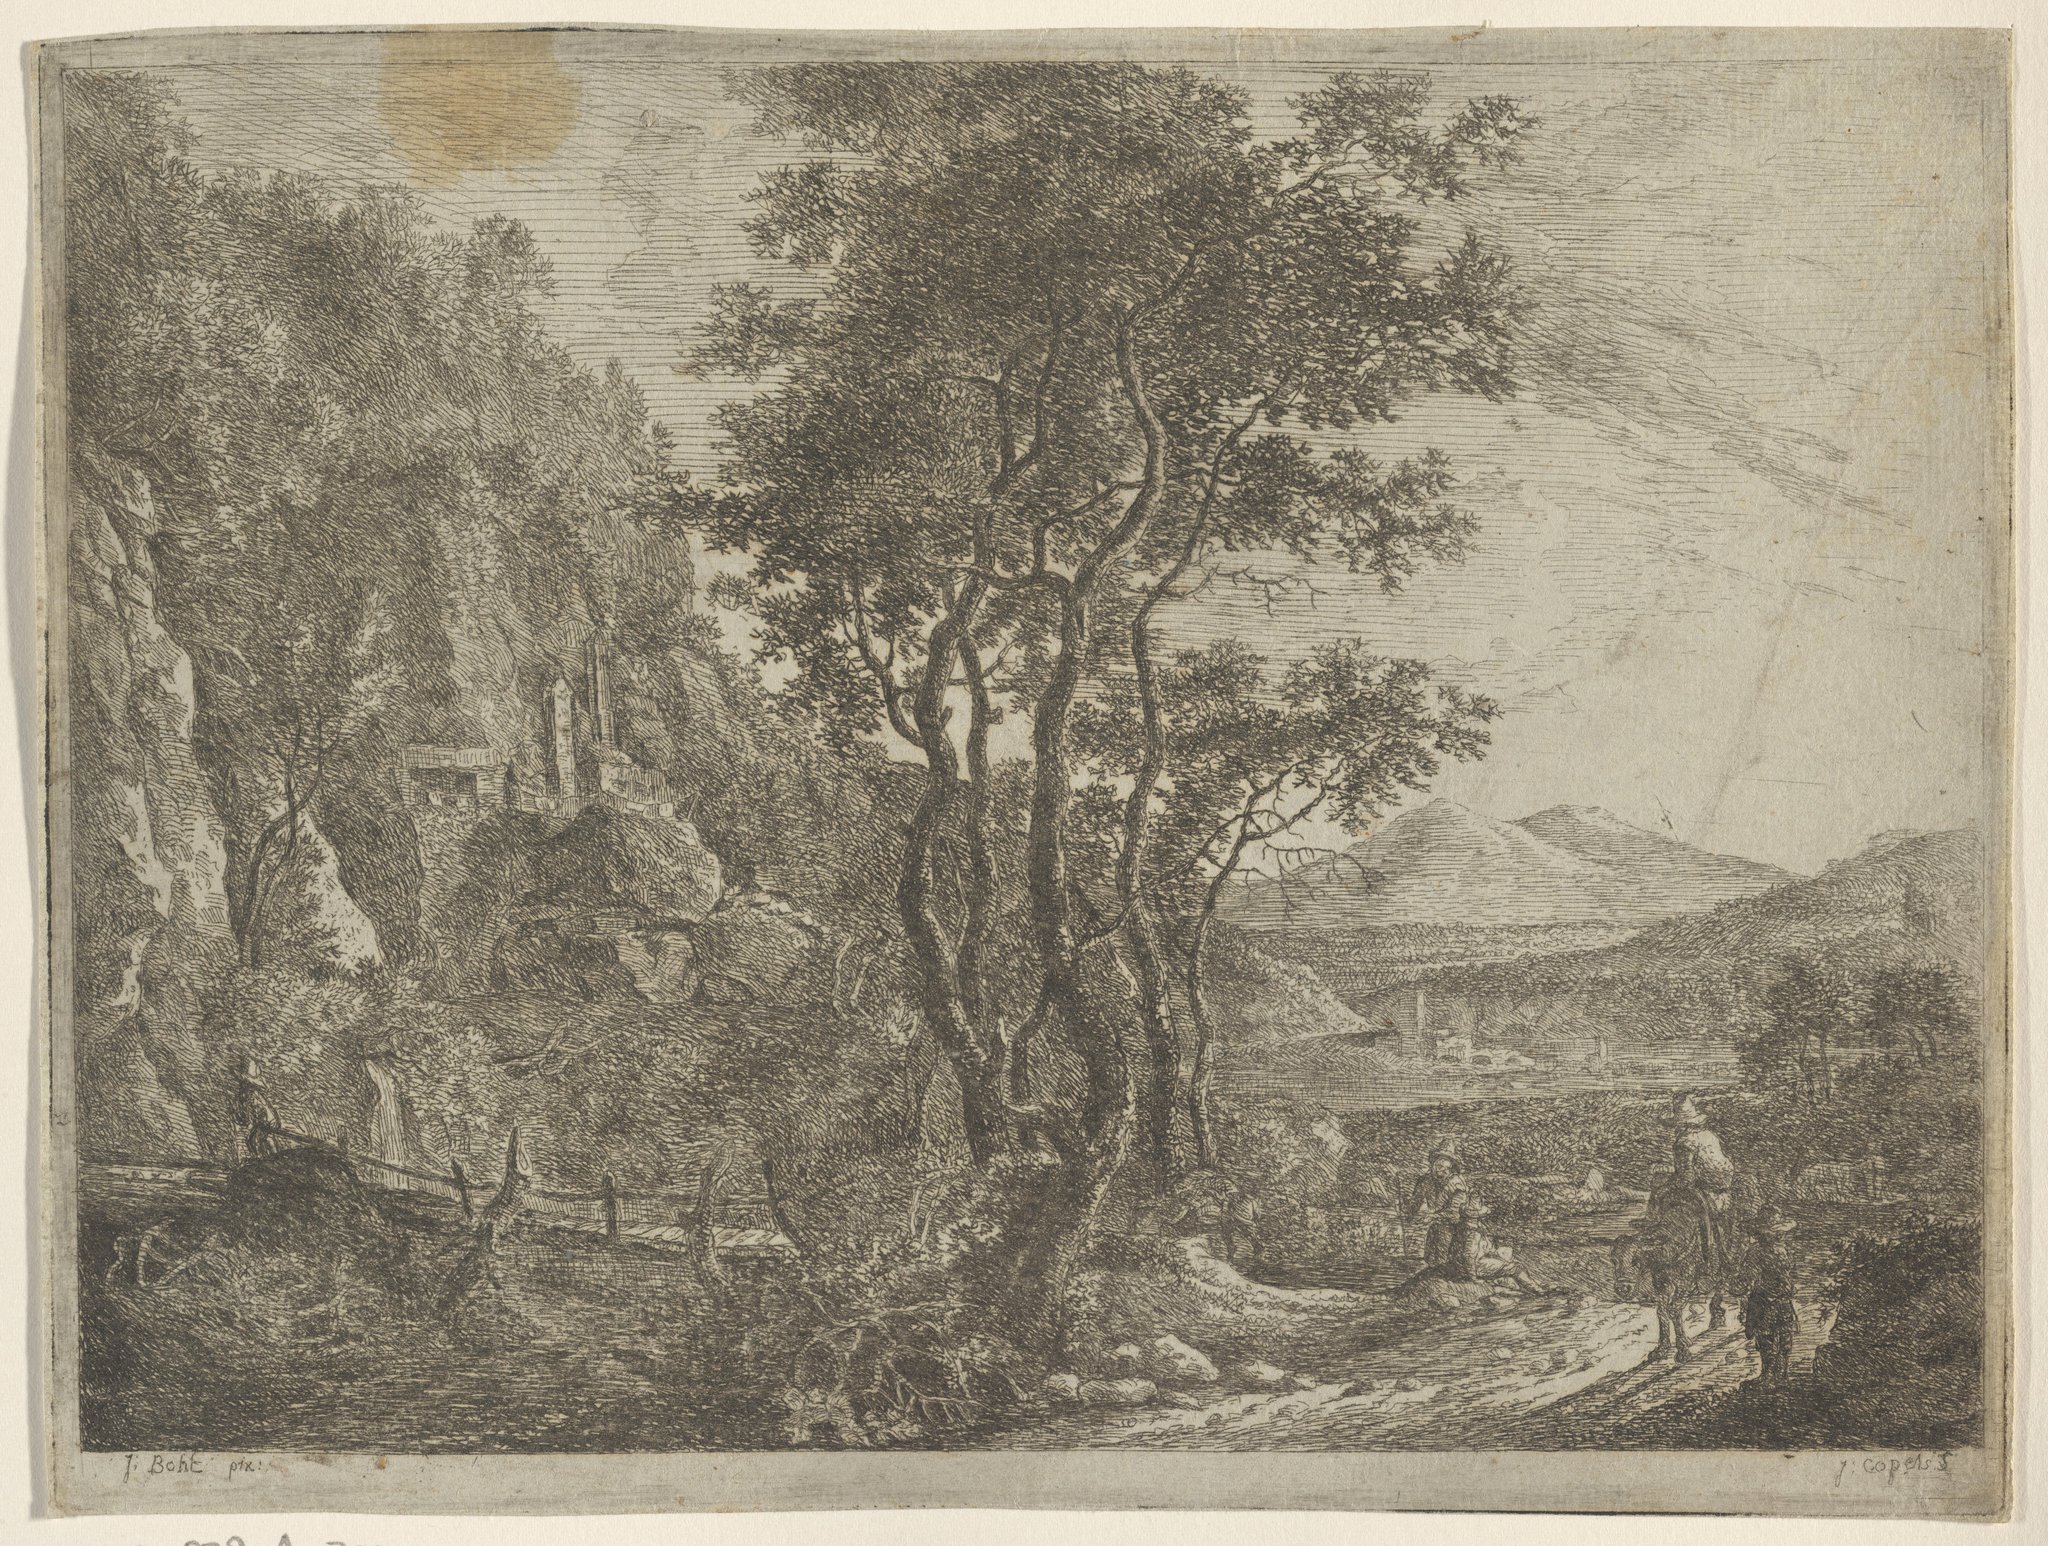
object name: print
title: Italiaans landschap met figuren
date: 1808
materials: paper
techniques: etching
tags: (high) hill, landscapes in the temperate zone (+ landscape with figures, staffage)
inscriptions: collector's mark: Lugt 2228